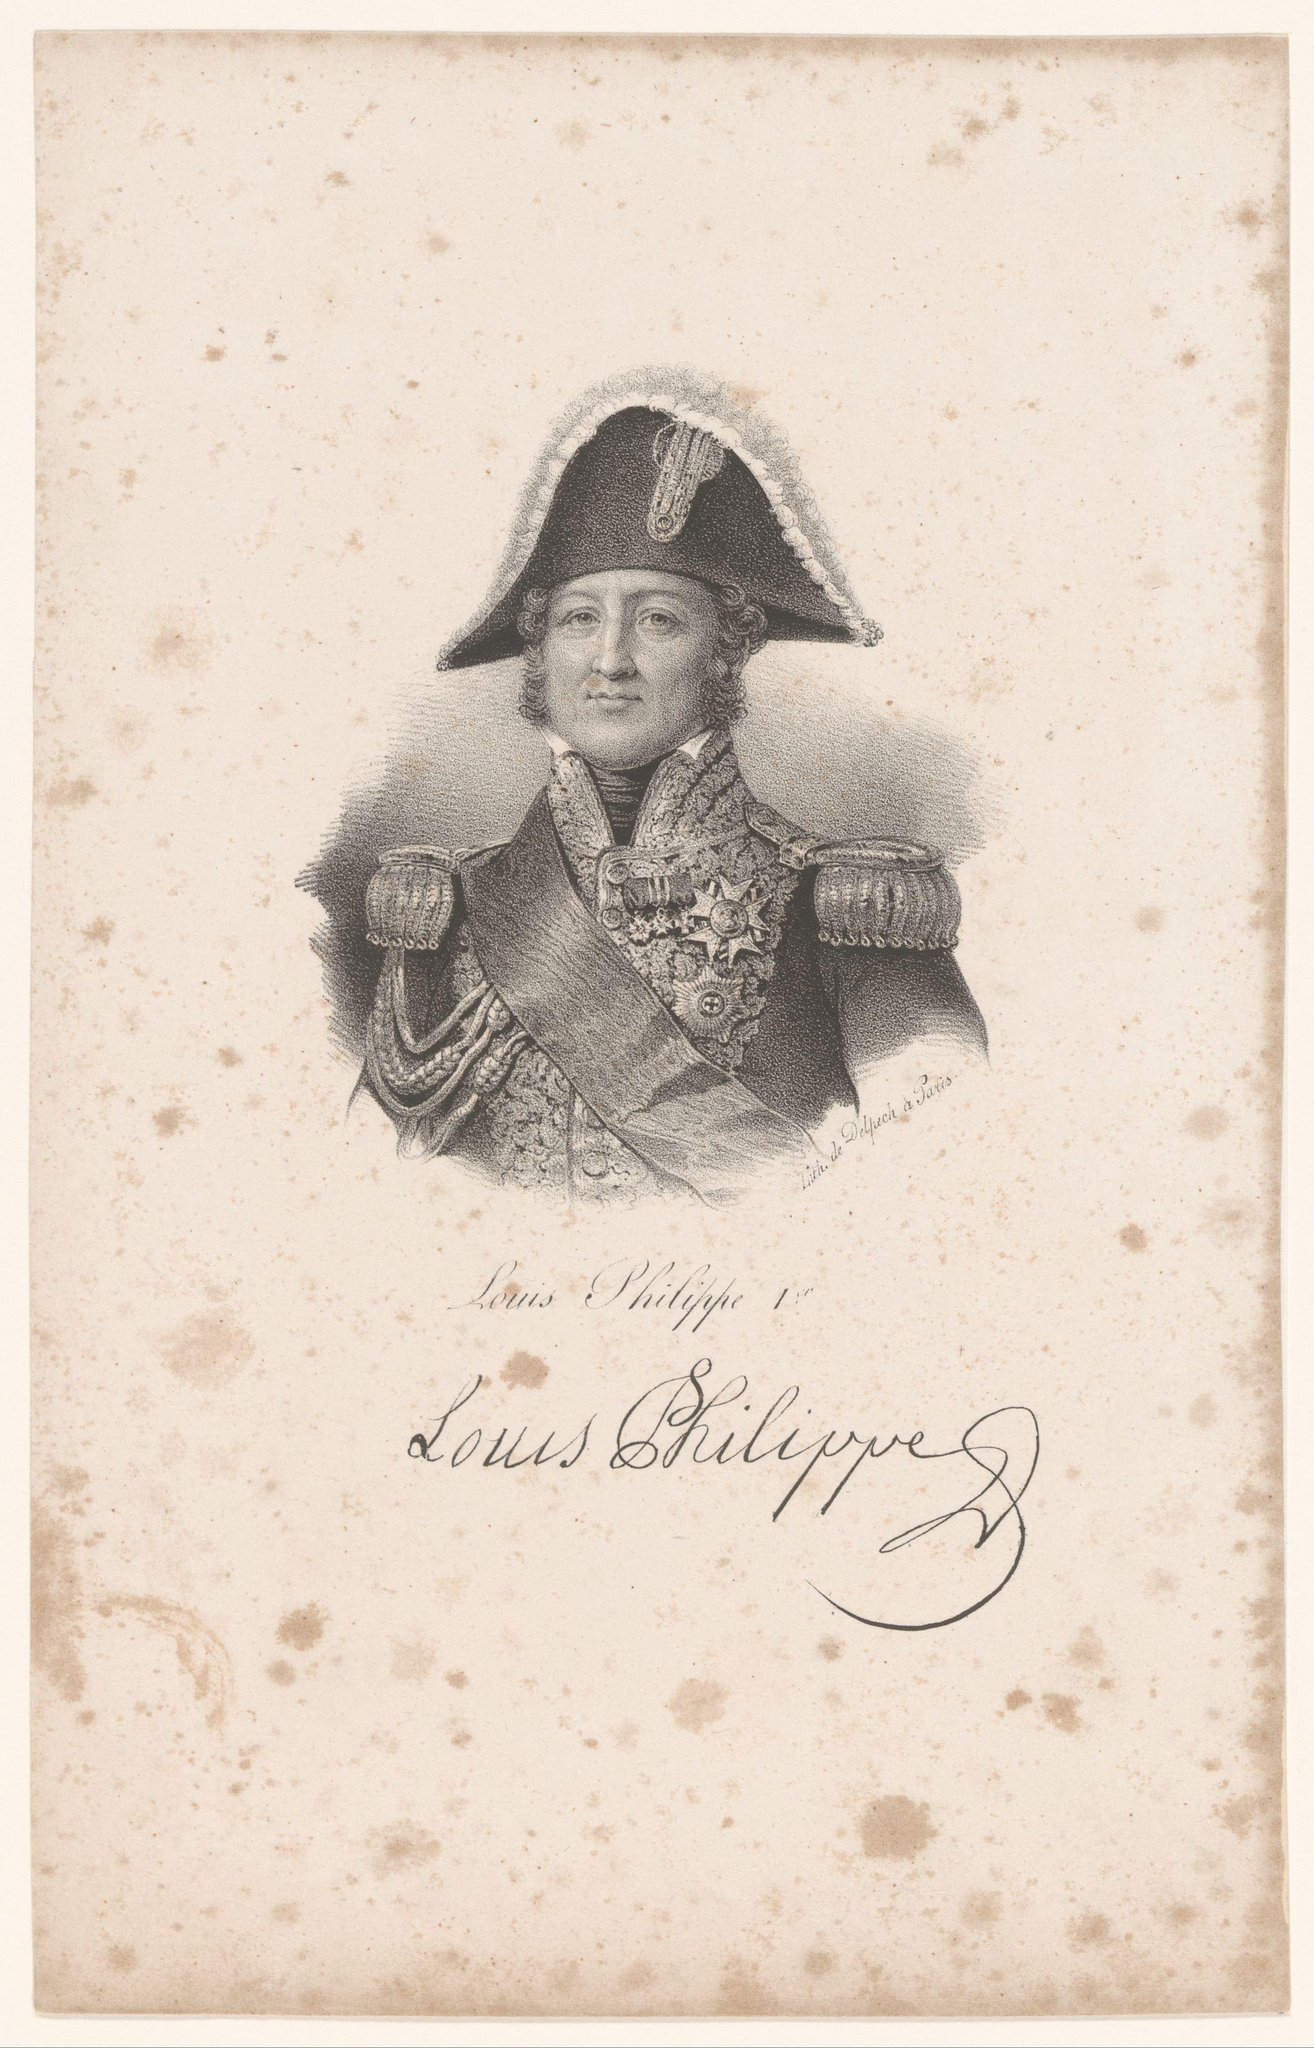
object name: print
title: Louis Philippe 1er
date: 1818-1842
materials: paper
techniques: lithograph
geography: paris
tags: lodewijk filips i (koning van frankrijk), historical persons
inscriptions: collector's mark: Lugt 2228a